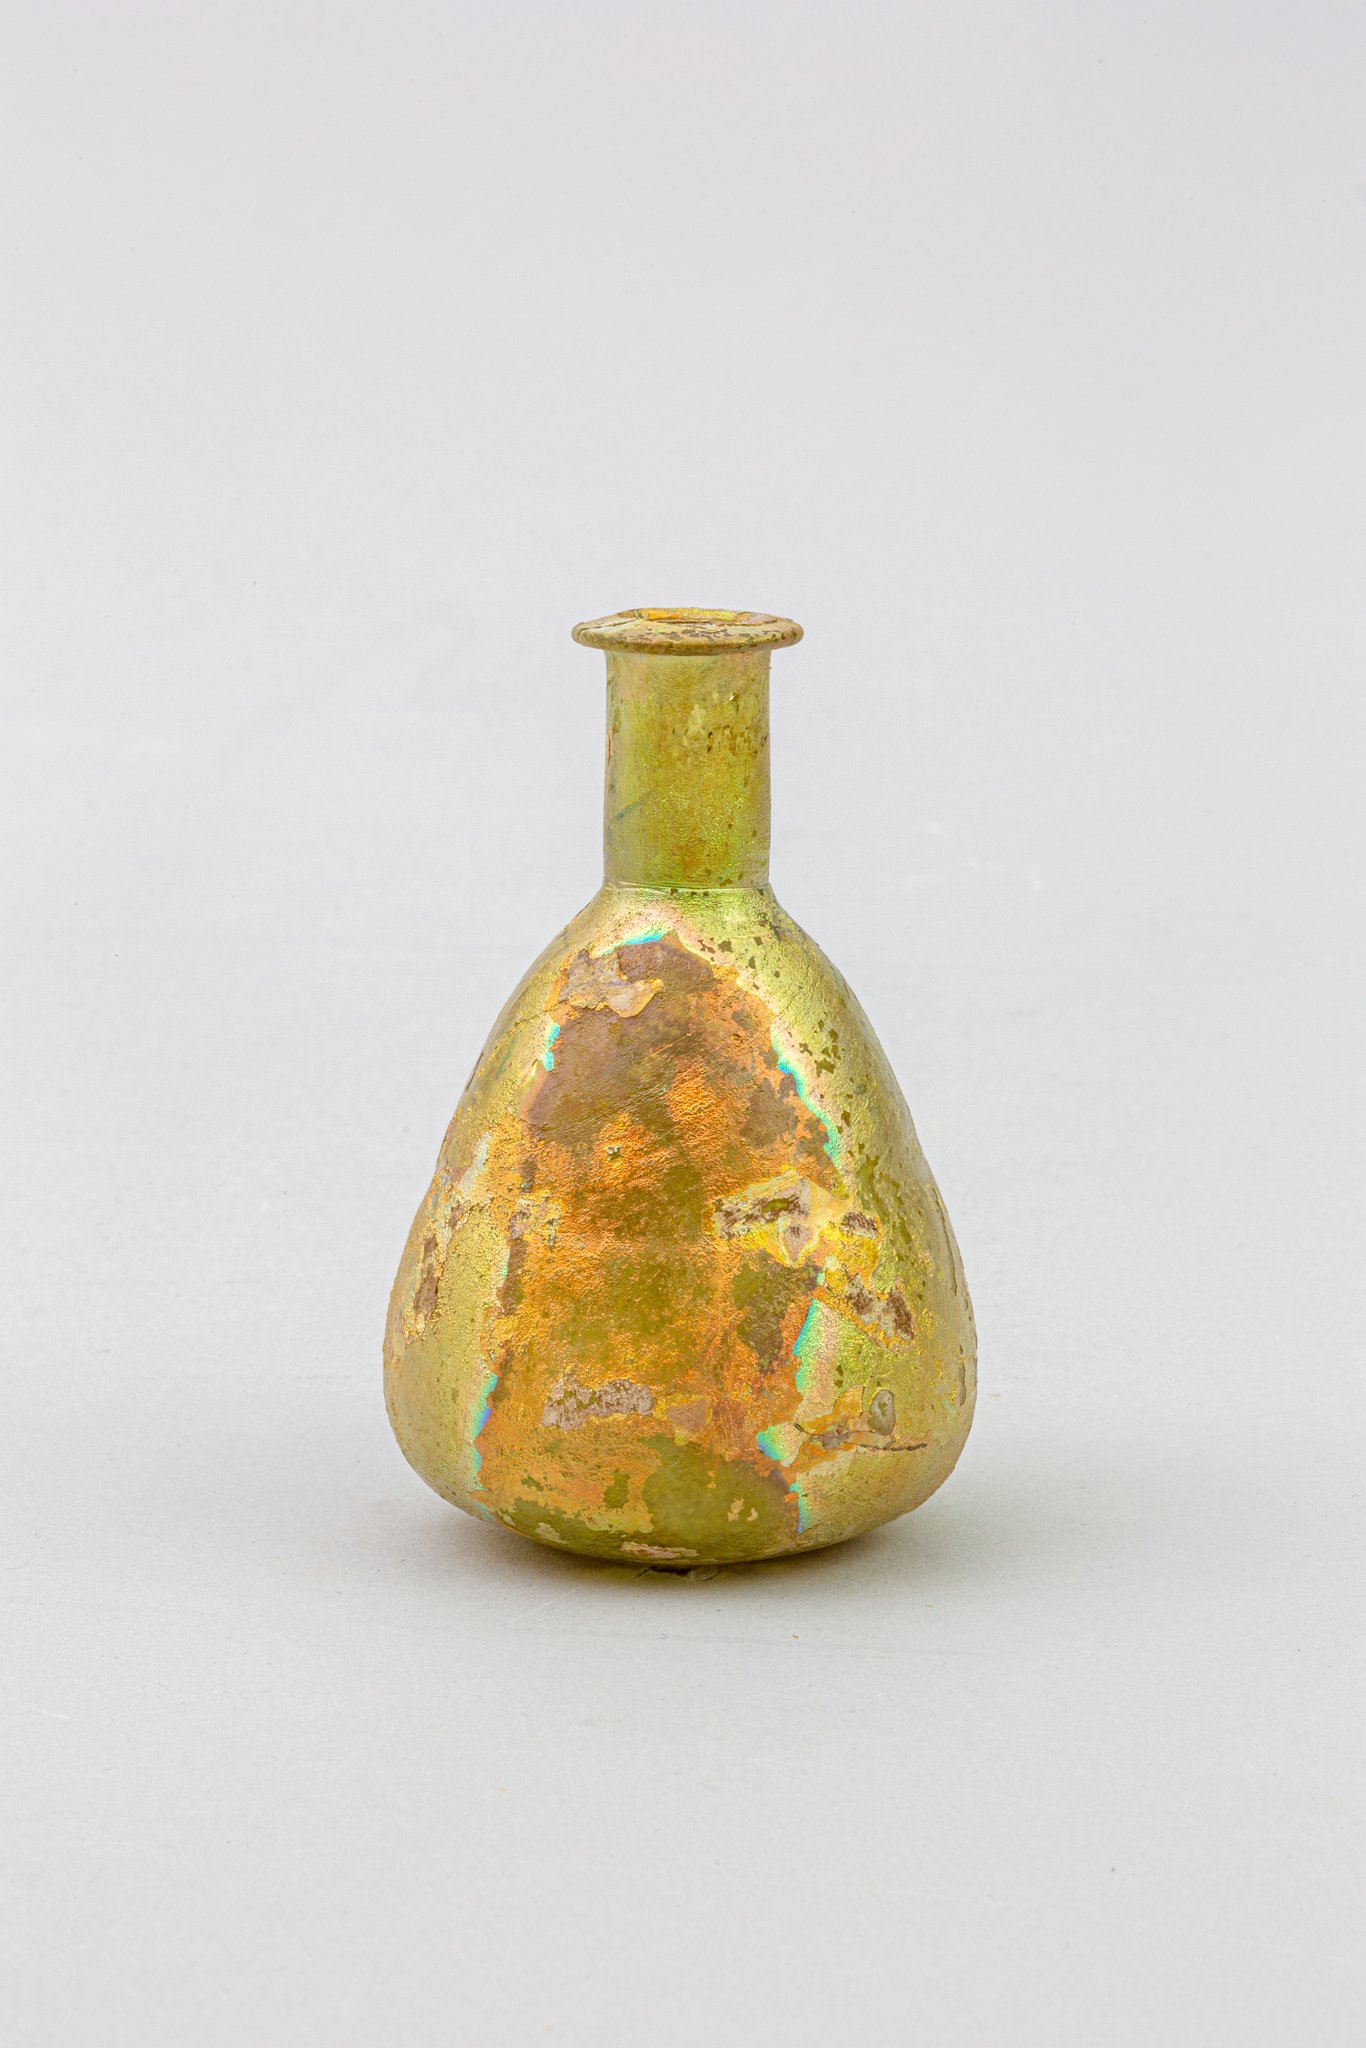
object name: bottle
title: Glass perfume bottle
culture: roman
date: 1-100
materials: glass